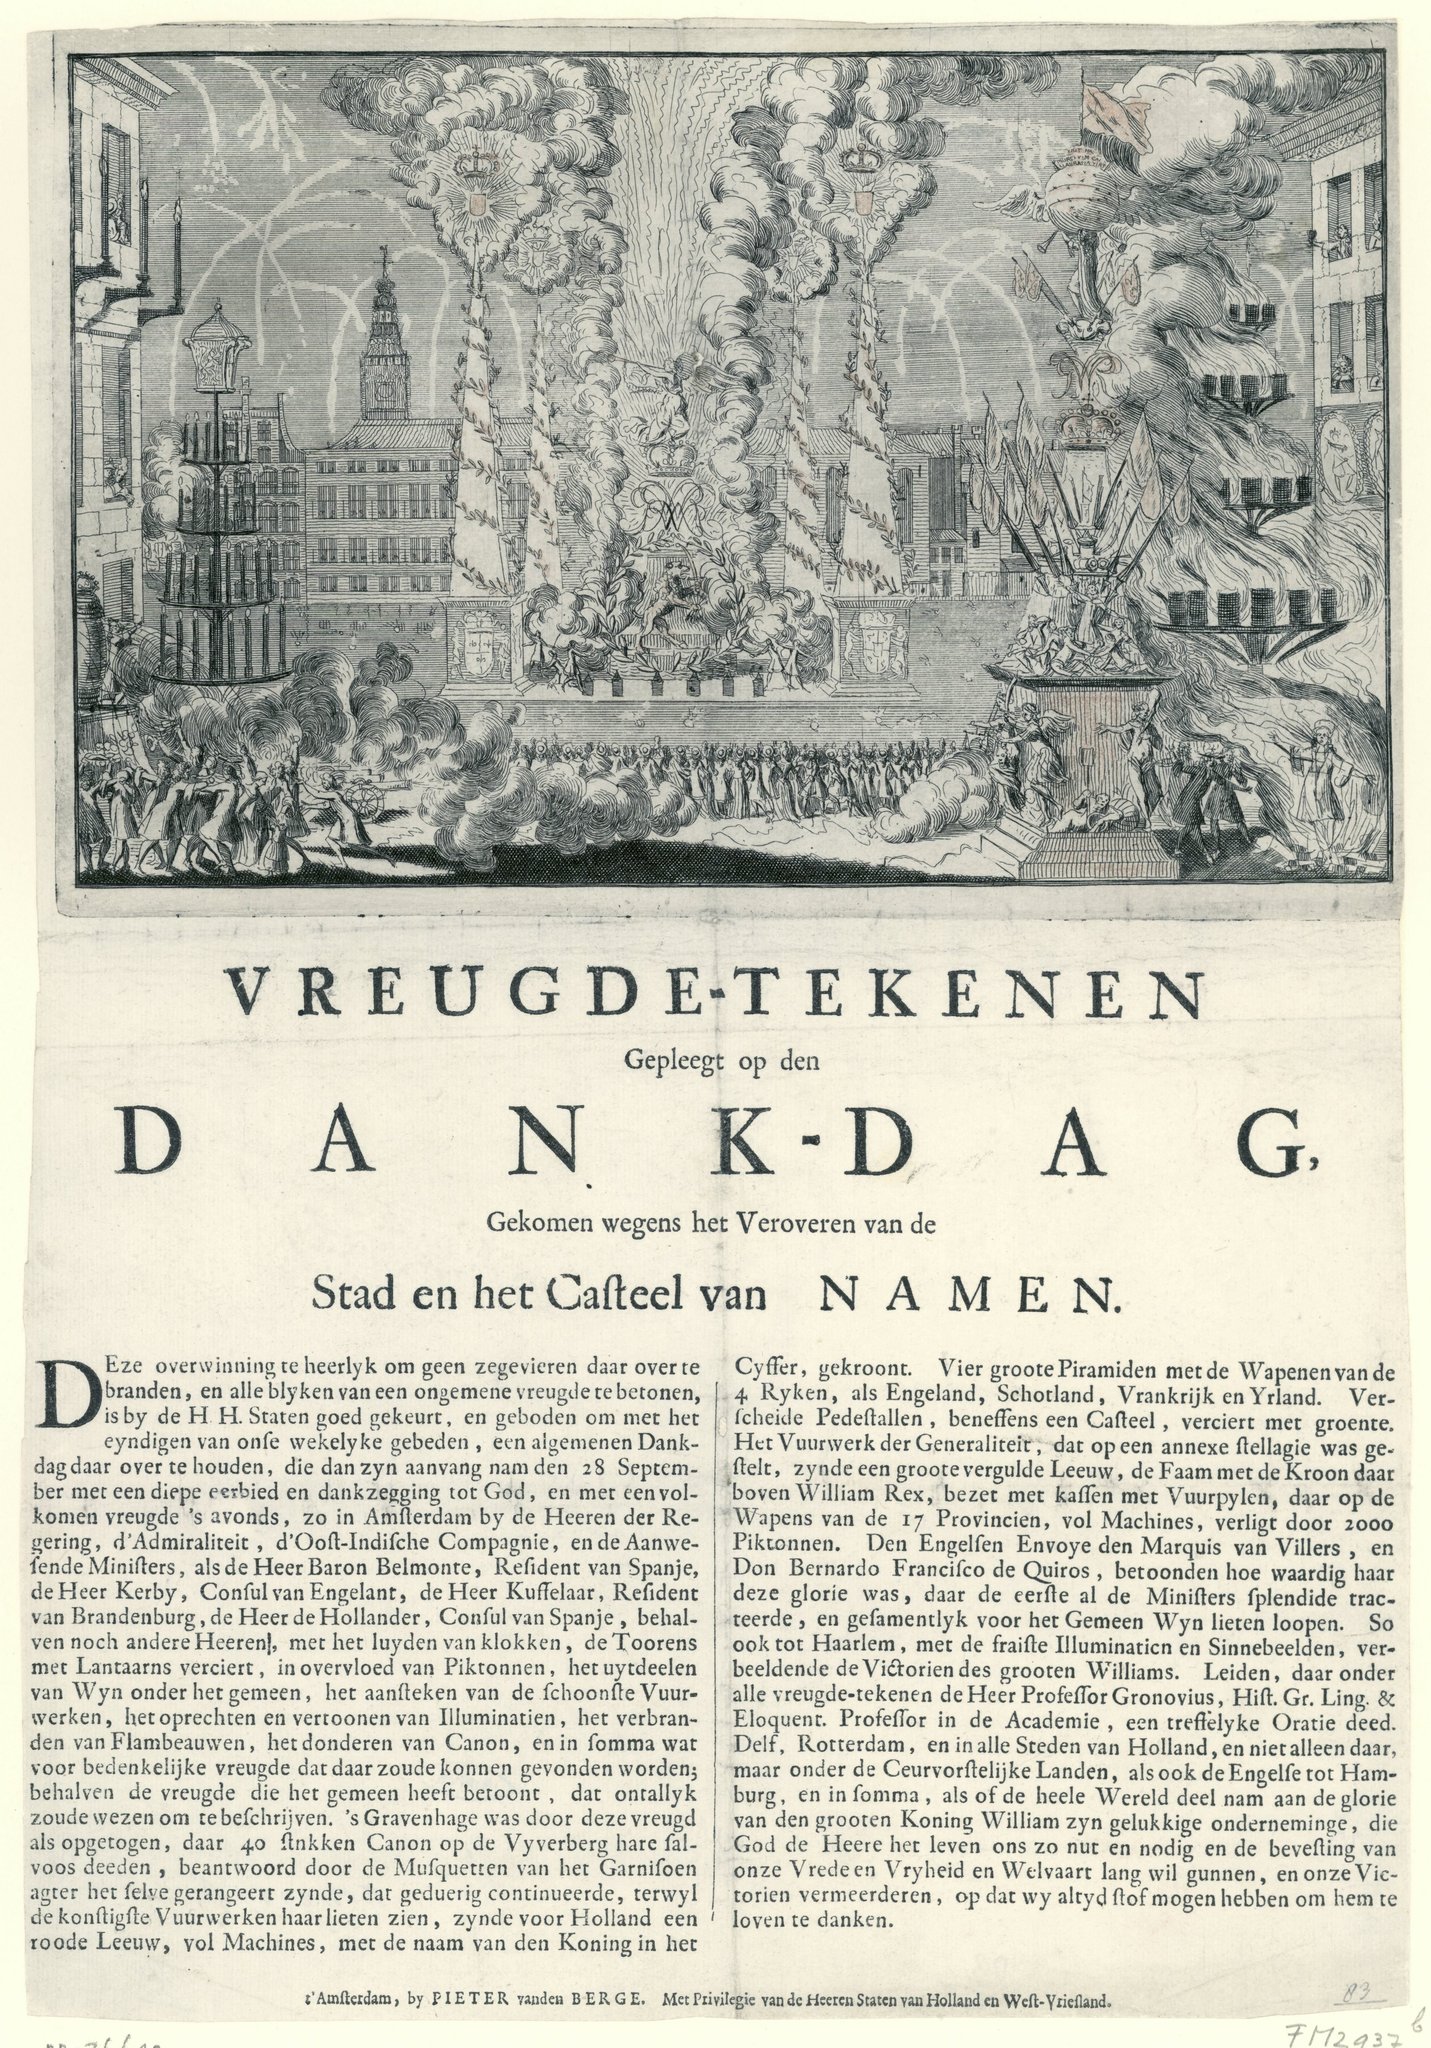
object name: print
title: Vreugdevuren te Den Haag na de verovering van Namen, 1695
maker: pieter van den berge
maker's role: draughtsman, print maker, printer, publisher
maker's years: 1659-1737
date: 1695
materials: chalk, paper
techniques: engraving, etching, letterpress printing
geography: amsterdam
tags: bonfire, fire-works, festivities (+ illumination, fire-works ~ festive activities)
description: Blad met een voorstelling en beschrijving van de viering van de verovering van Namen door de geallieerden (op 5 september) bij de Vijverberg in Den Haag op 28 september 1695. Stellages, vreugdevuren en vuurwerk. Verschillende onderdelen van de prent zijn met rood krijt gekleurd. Onder de voorstelling een beschrijving in twee kolommen.